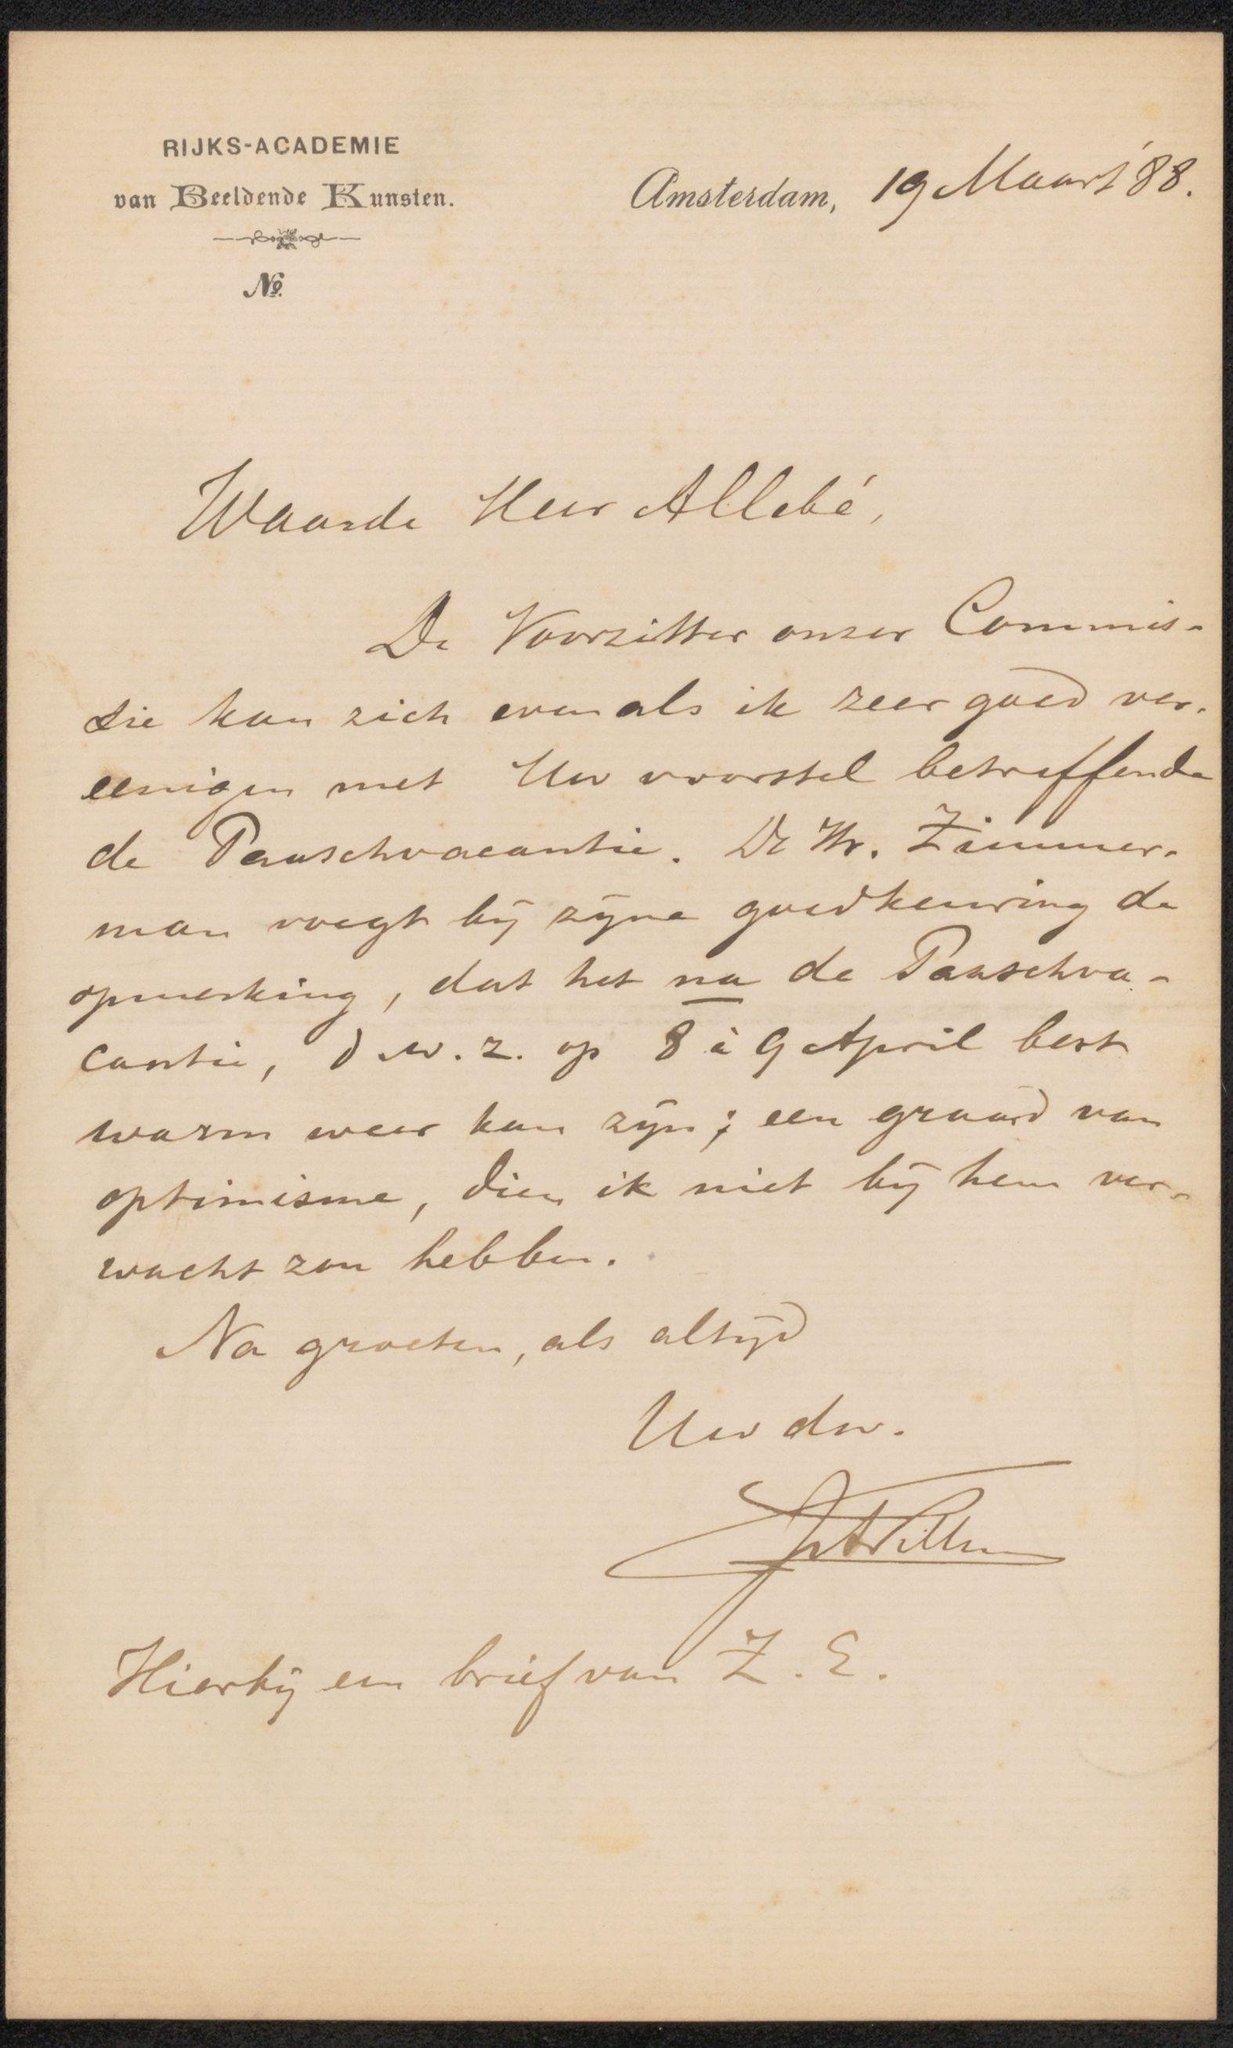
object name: letter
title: Brief aan August Allebé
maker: jérôme alexander sillem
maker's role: politician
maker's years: 1840-1912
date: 1888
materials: ink, paper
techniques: pen, printing, writing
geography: amsterdam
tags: august allebé, education, tuition of the artist (in general)